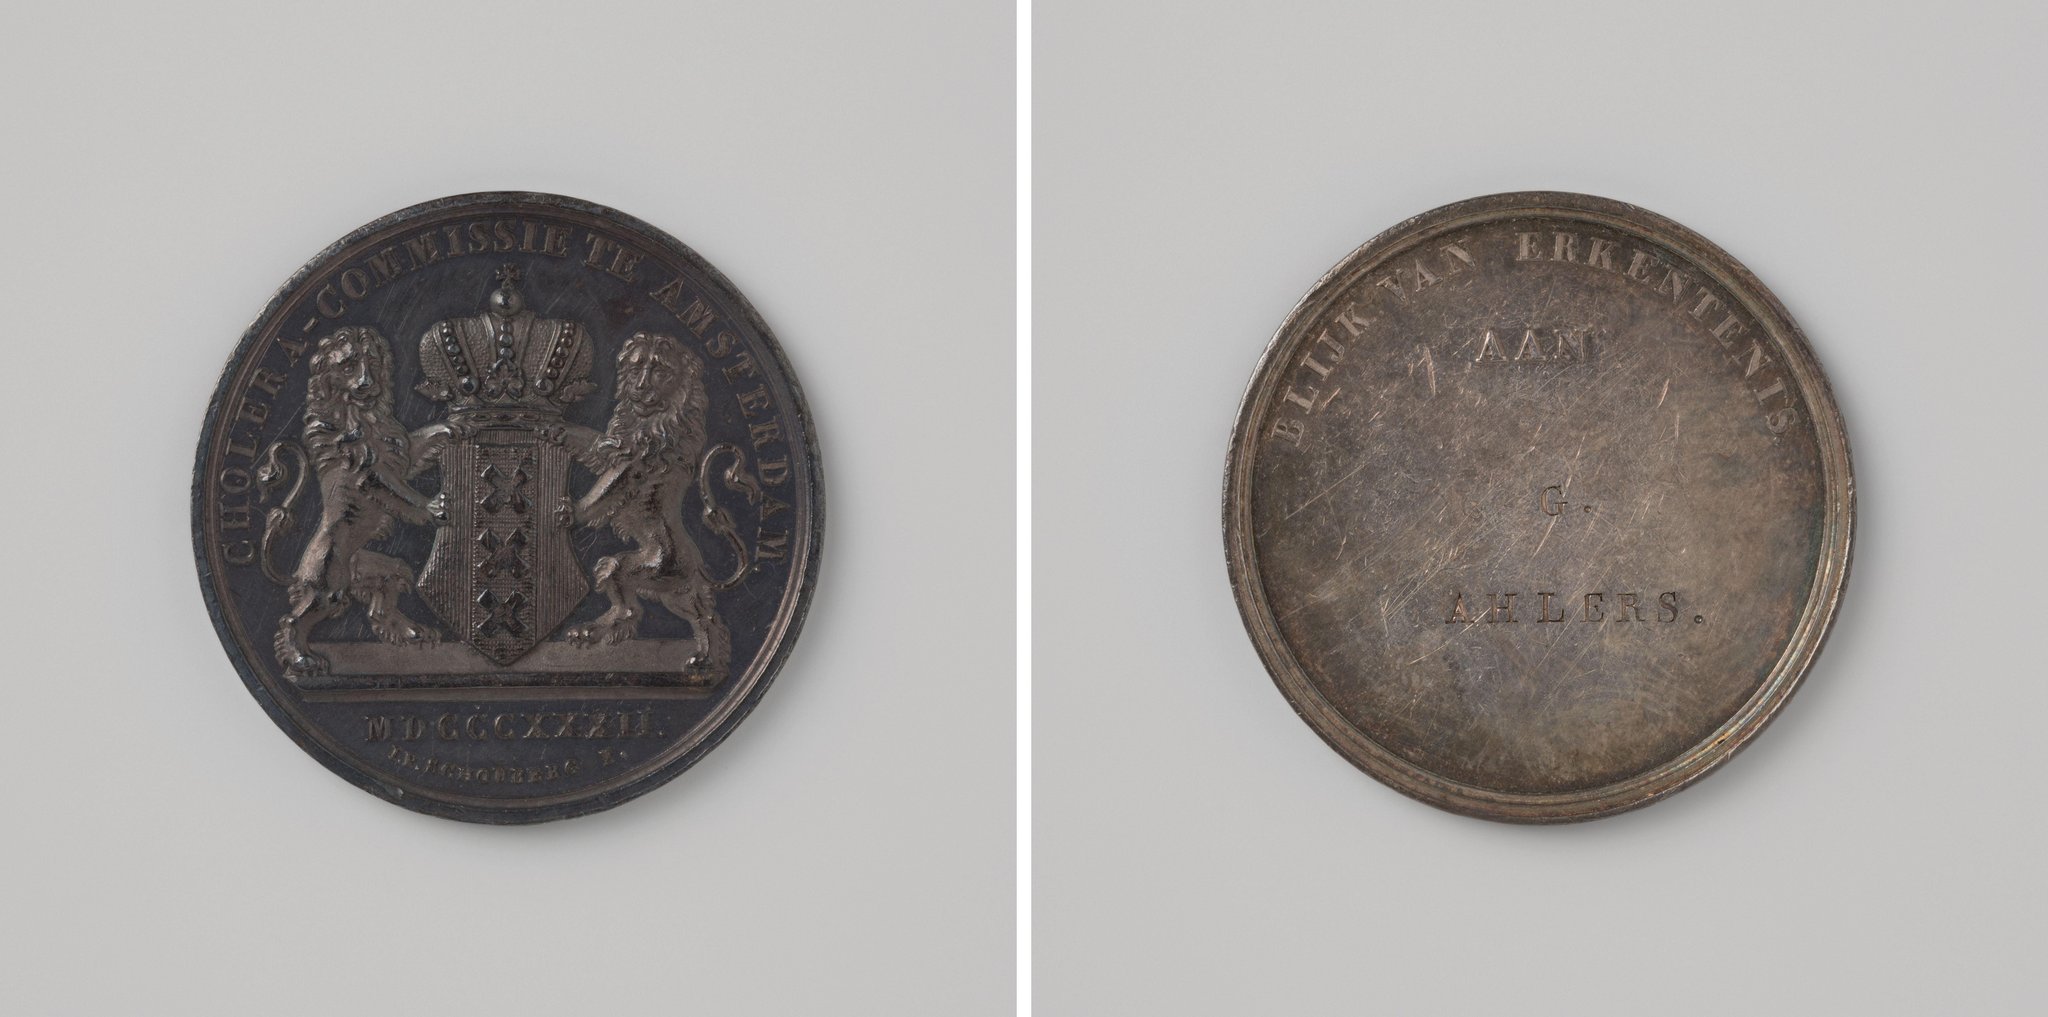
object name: history medal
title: Erepenning voor de wijkmeesters te Amsterdam bij de choleraepidemie 1832 op naam van G. Ahlers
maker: johannis petrus schouberg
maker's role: die cutter, draughtsman, print maker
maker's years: 1798-1864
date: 1832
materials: silver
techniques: printing, striking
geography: utrecht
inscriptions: inscription: ‘G. / AHLERS.’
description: Zilveren penning, op de voorzijde het gekroonde wapenschild van Amsterdam met dragers, met omschrift en afsnedetekst, op de keerzijde BLIJK VAN ERKENTENIS AAN waaronder inscriptieruimte.